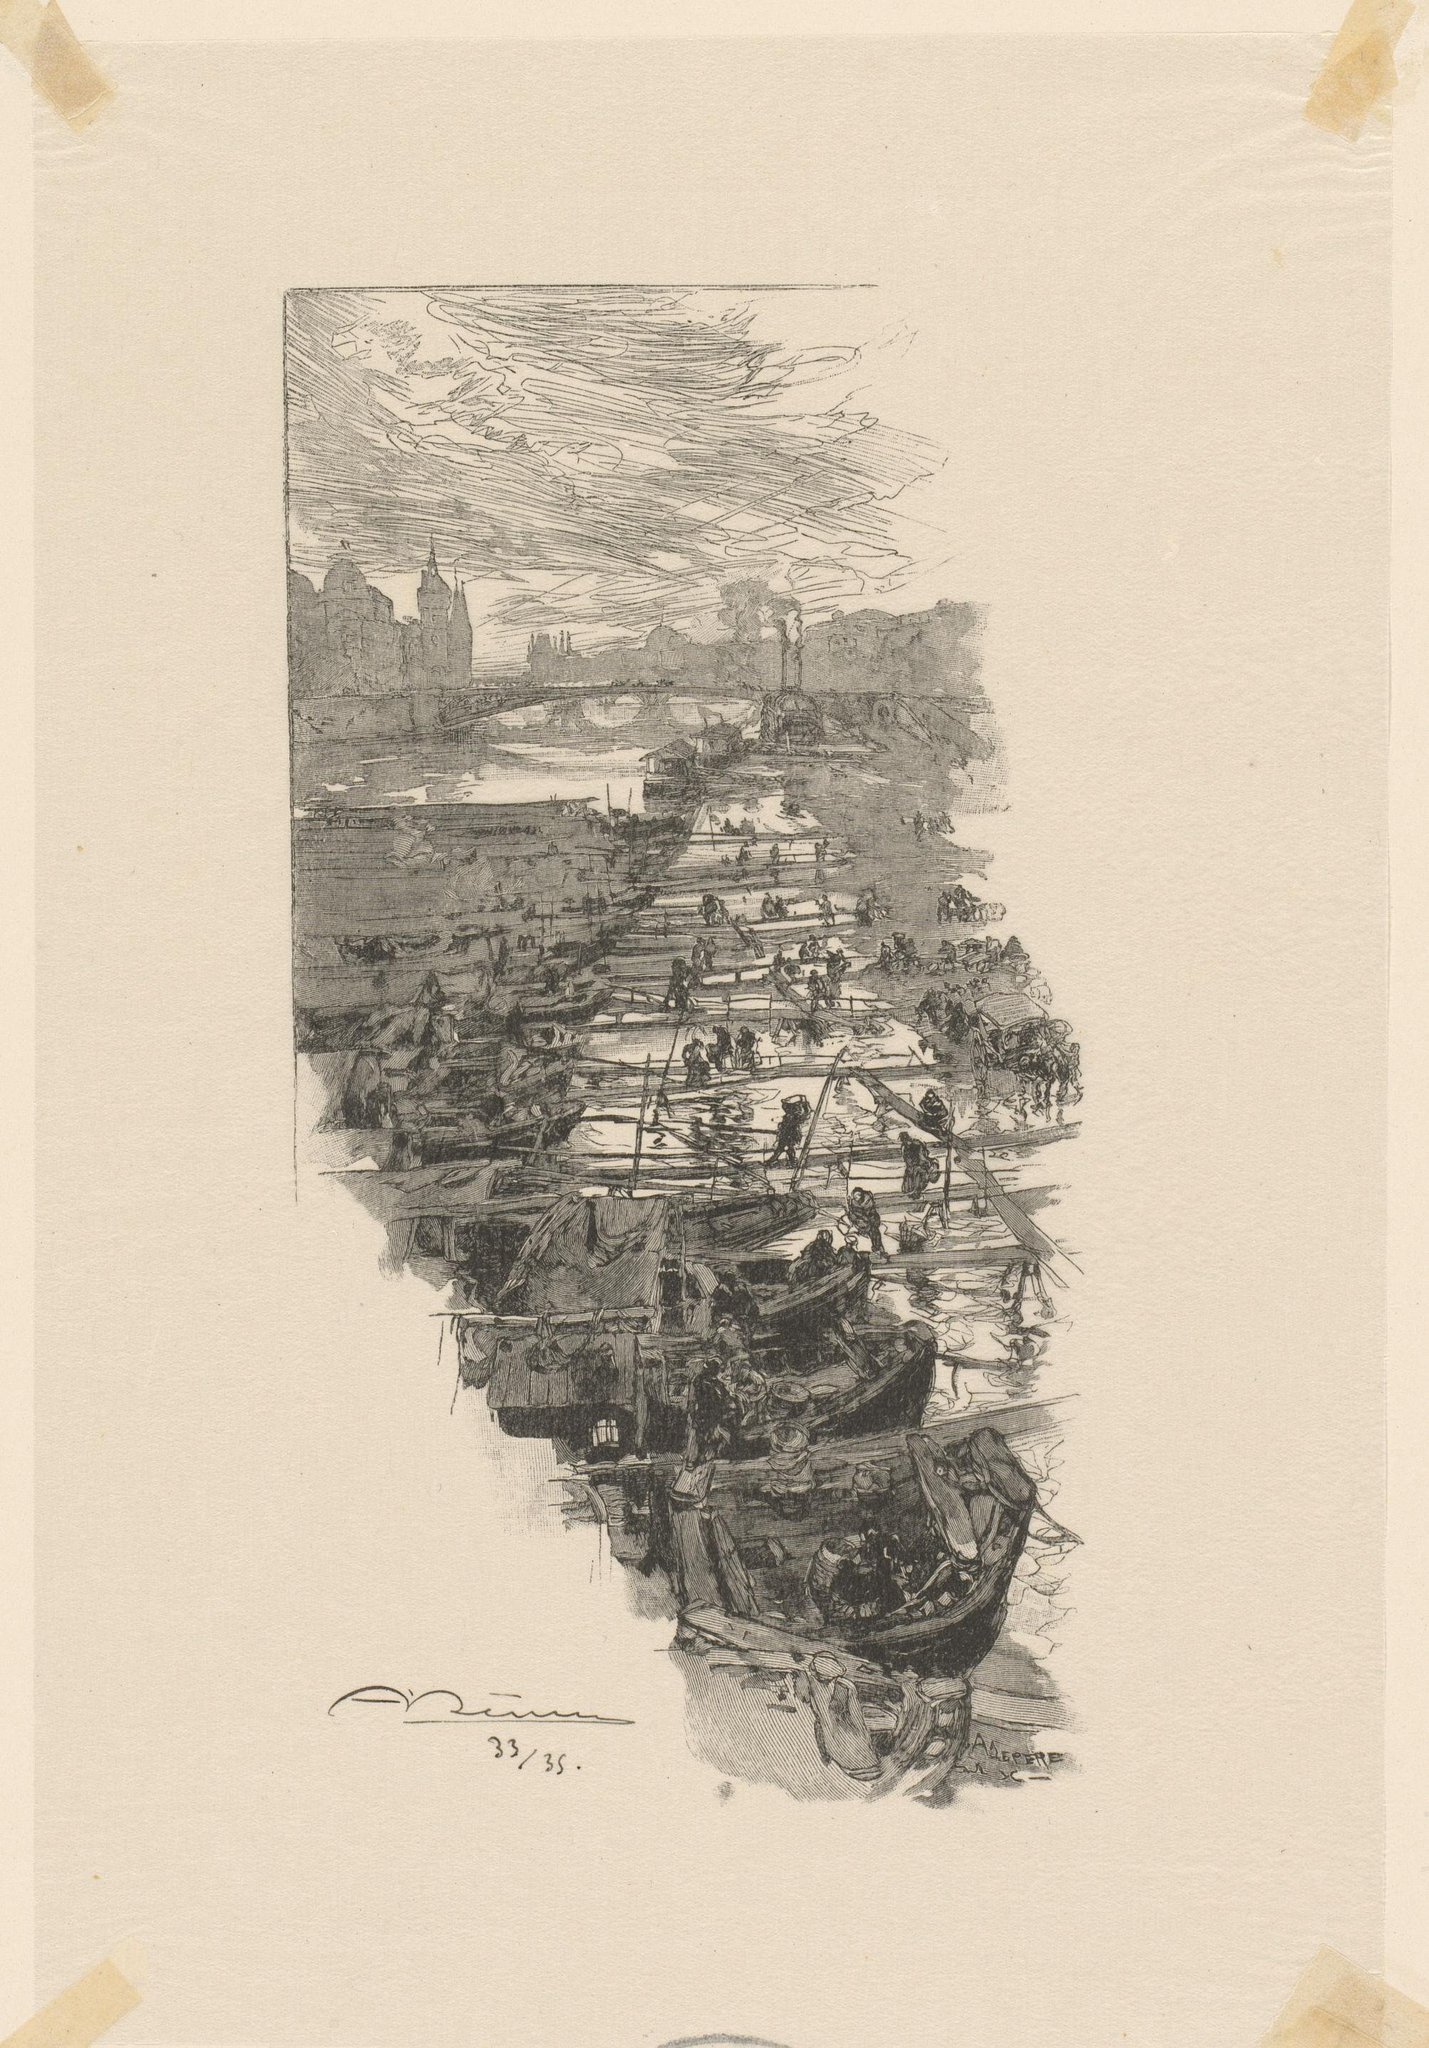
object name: print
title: L'Oeuvre gravé sur bois de Auguste Lepère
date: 1910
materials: paper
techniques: engraving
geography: paris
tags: sailing-ship, sailing-boat, bridge in city across river, canal, etc., paris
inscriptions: collector's mark: Lugt 2228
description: Deze serie heeft als titel 'Le long de la Seine et des boulevards'. Deze serie is het vierde deel van het grotere geheel 'L'Oeuvre gravé sur bois de Auguste Lepère'.